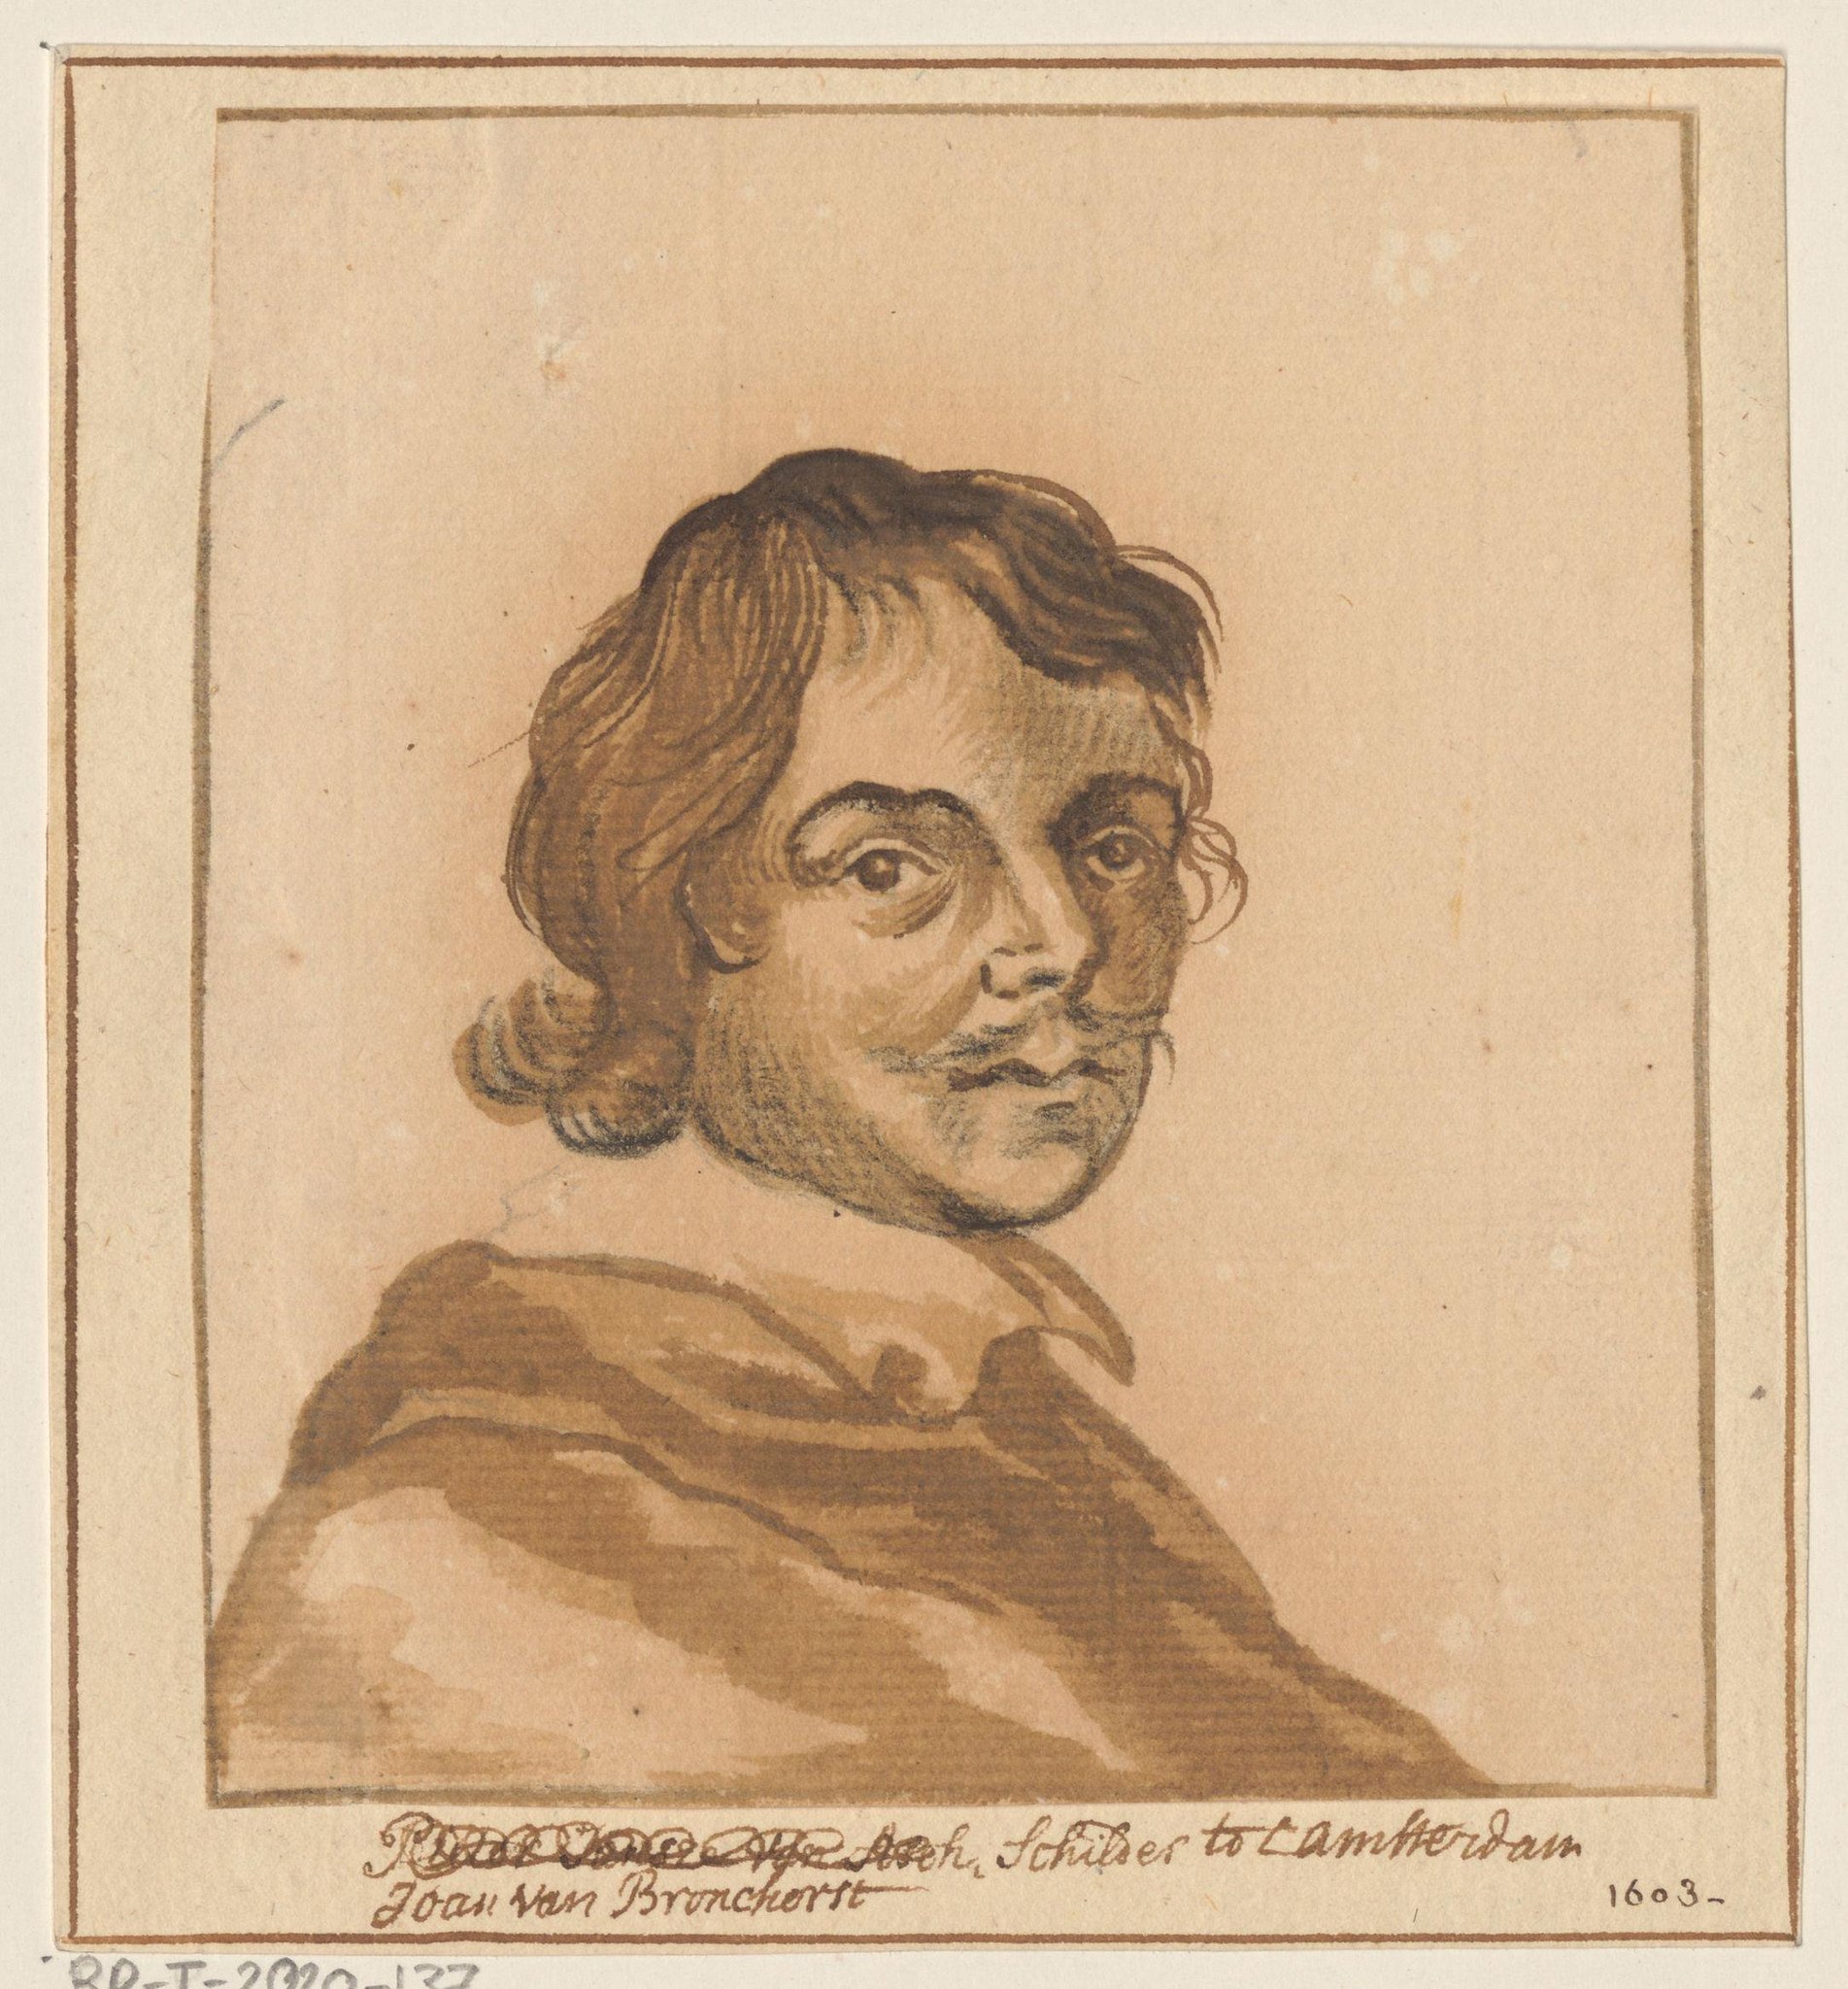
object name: drawing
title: Portret van Jan Gerritsz. van Bronckhorst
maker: Anonymous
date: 1700-1799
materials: paper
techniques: brush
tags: utrecht, amsterdam, print maker, draughtsman, jan gerritsz. van bronckhorst, historical persons, portrait, self-portrait of painter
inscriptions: inscription: ‘Joan van Bronchorst, schilder te Amsterdam’